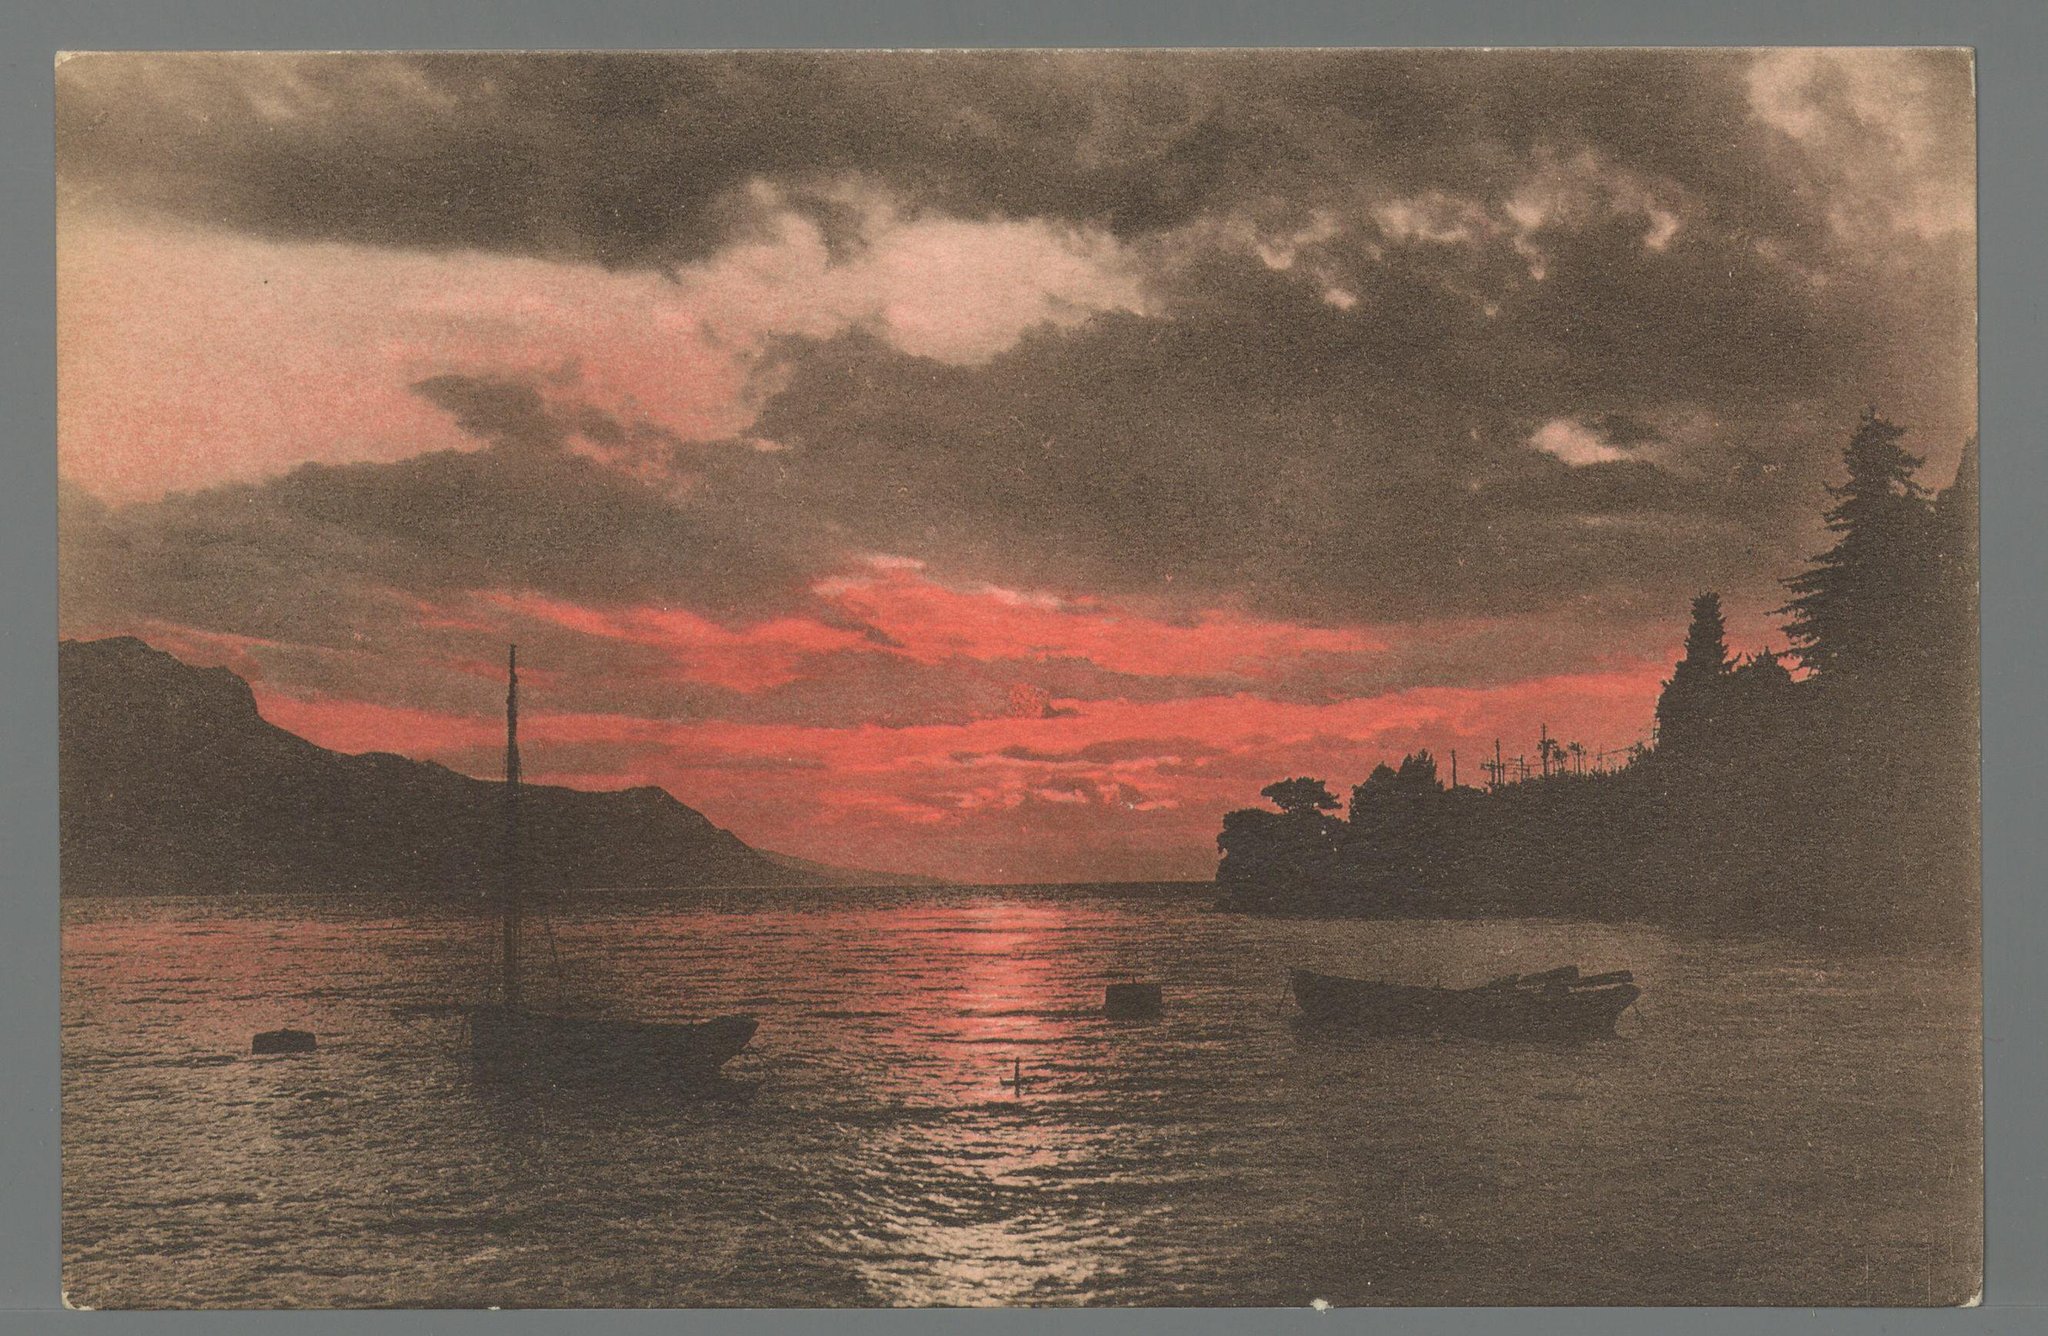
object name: ansichtkaart, prentbriefkaart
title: Lac Léman. Coucher de Soleil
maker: Anonymous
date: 1905-1909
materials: cardboard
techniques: photograph, lithograph, writing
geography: lake geneva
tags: ships (in general), lake, sunset